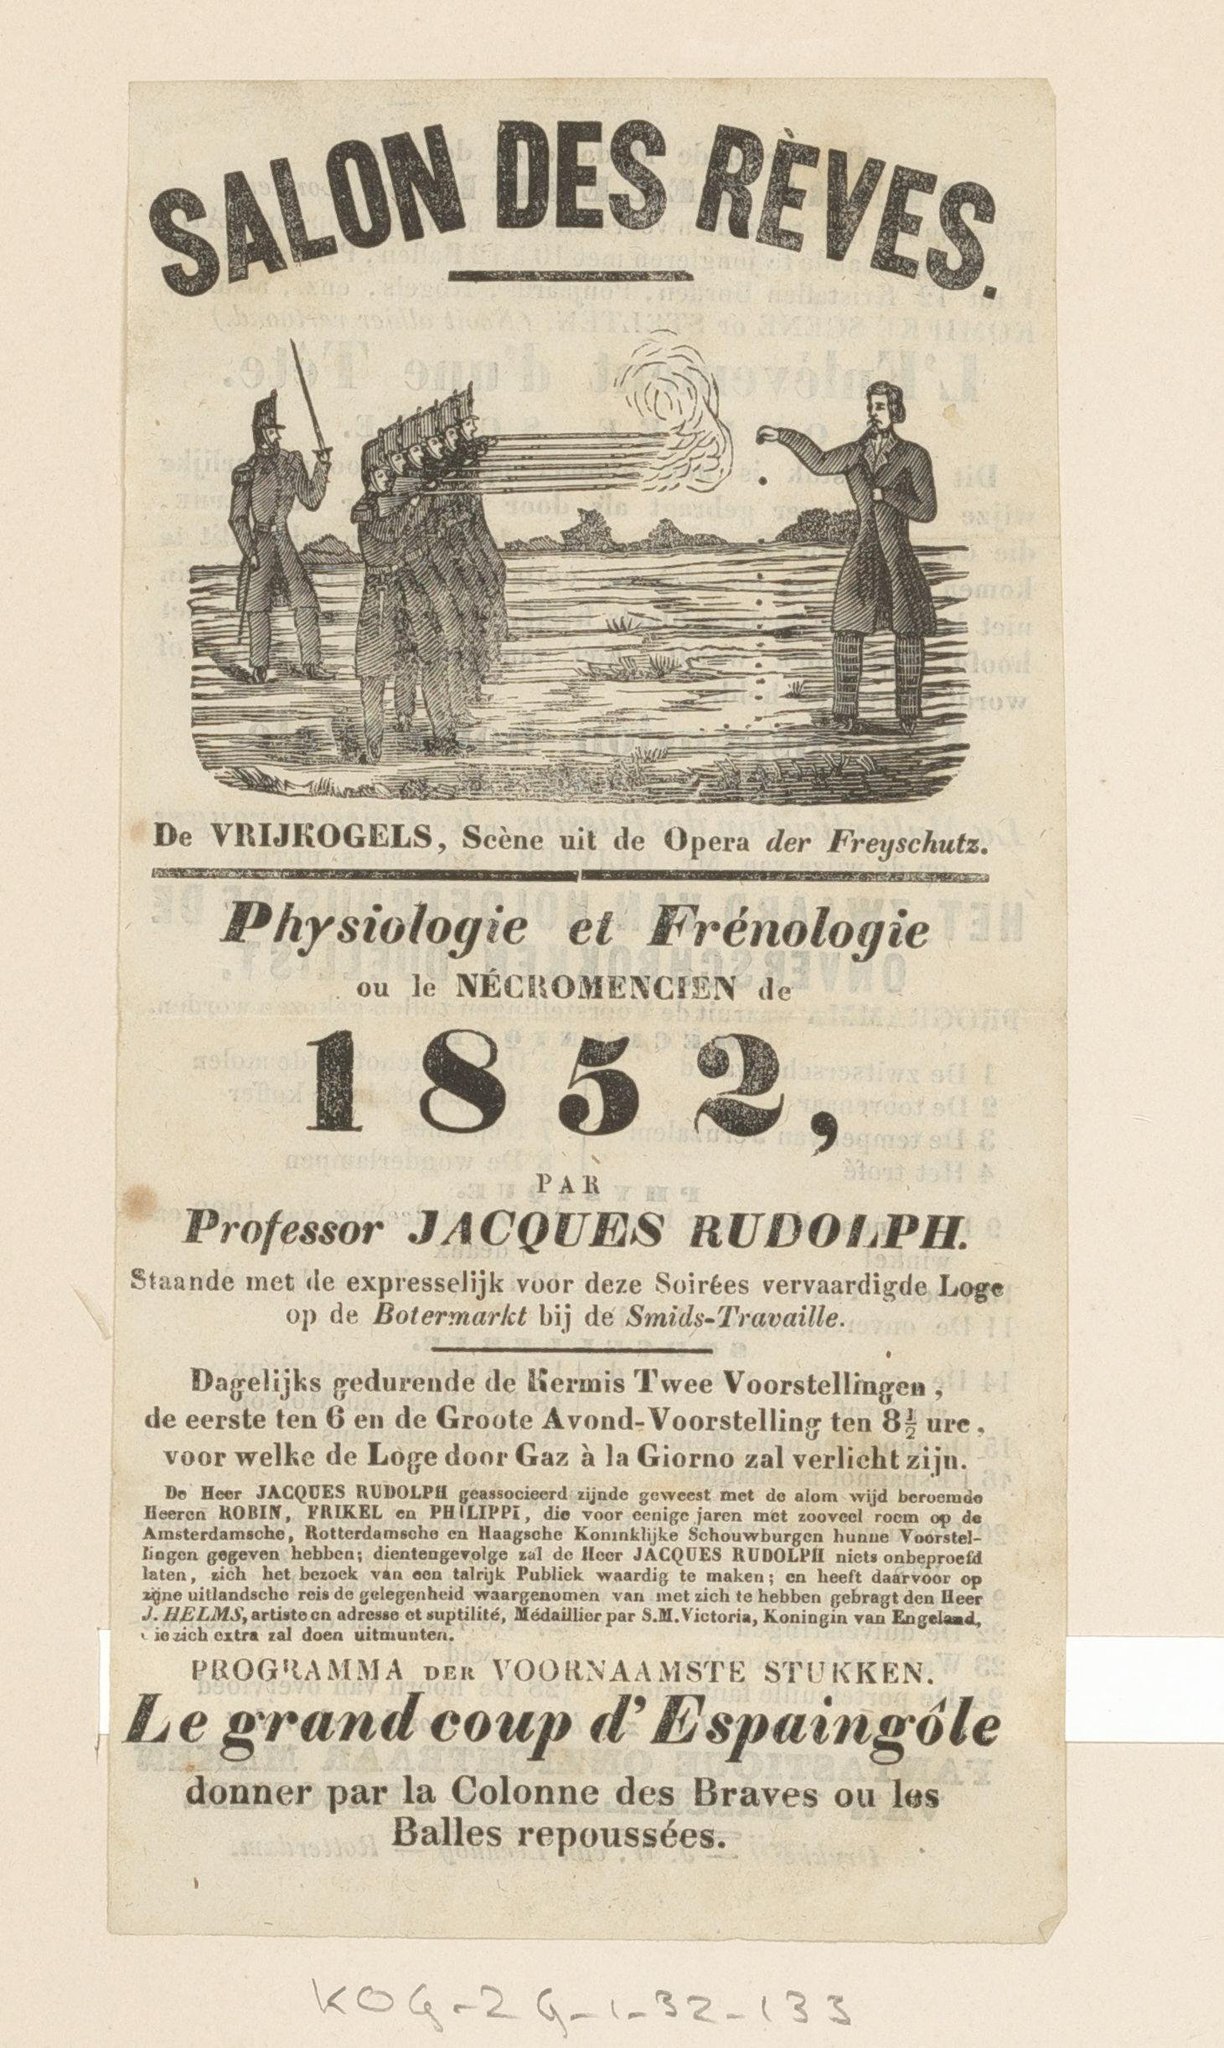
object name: reclamebiljet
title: Salon des Rèves. De Vrijkogels, scène uit de Opera der Freyschutz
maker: leenhoff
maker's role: printer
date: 1852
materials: paper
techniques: letterpress printing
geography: rotterdam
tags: illusionist, conjurer, juggler, 'legerdemain', pleasure fair and circus, violent death by fusillade, amsterdam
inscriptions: collector's mark, collector's mark: Lugt 1641